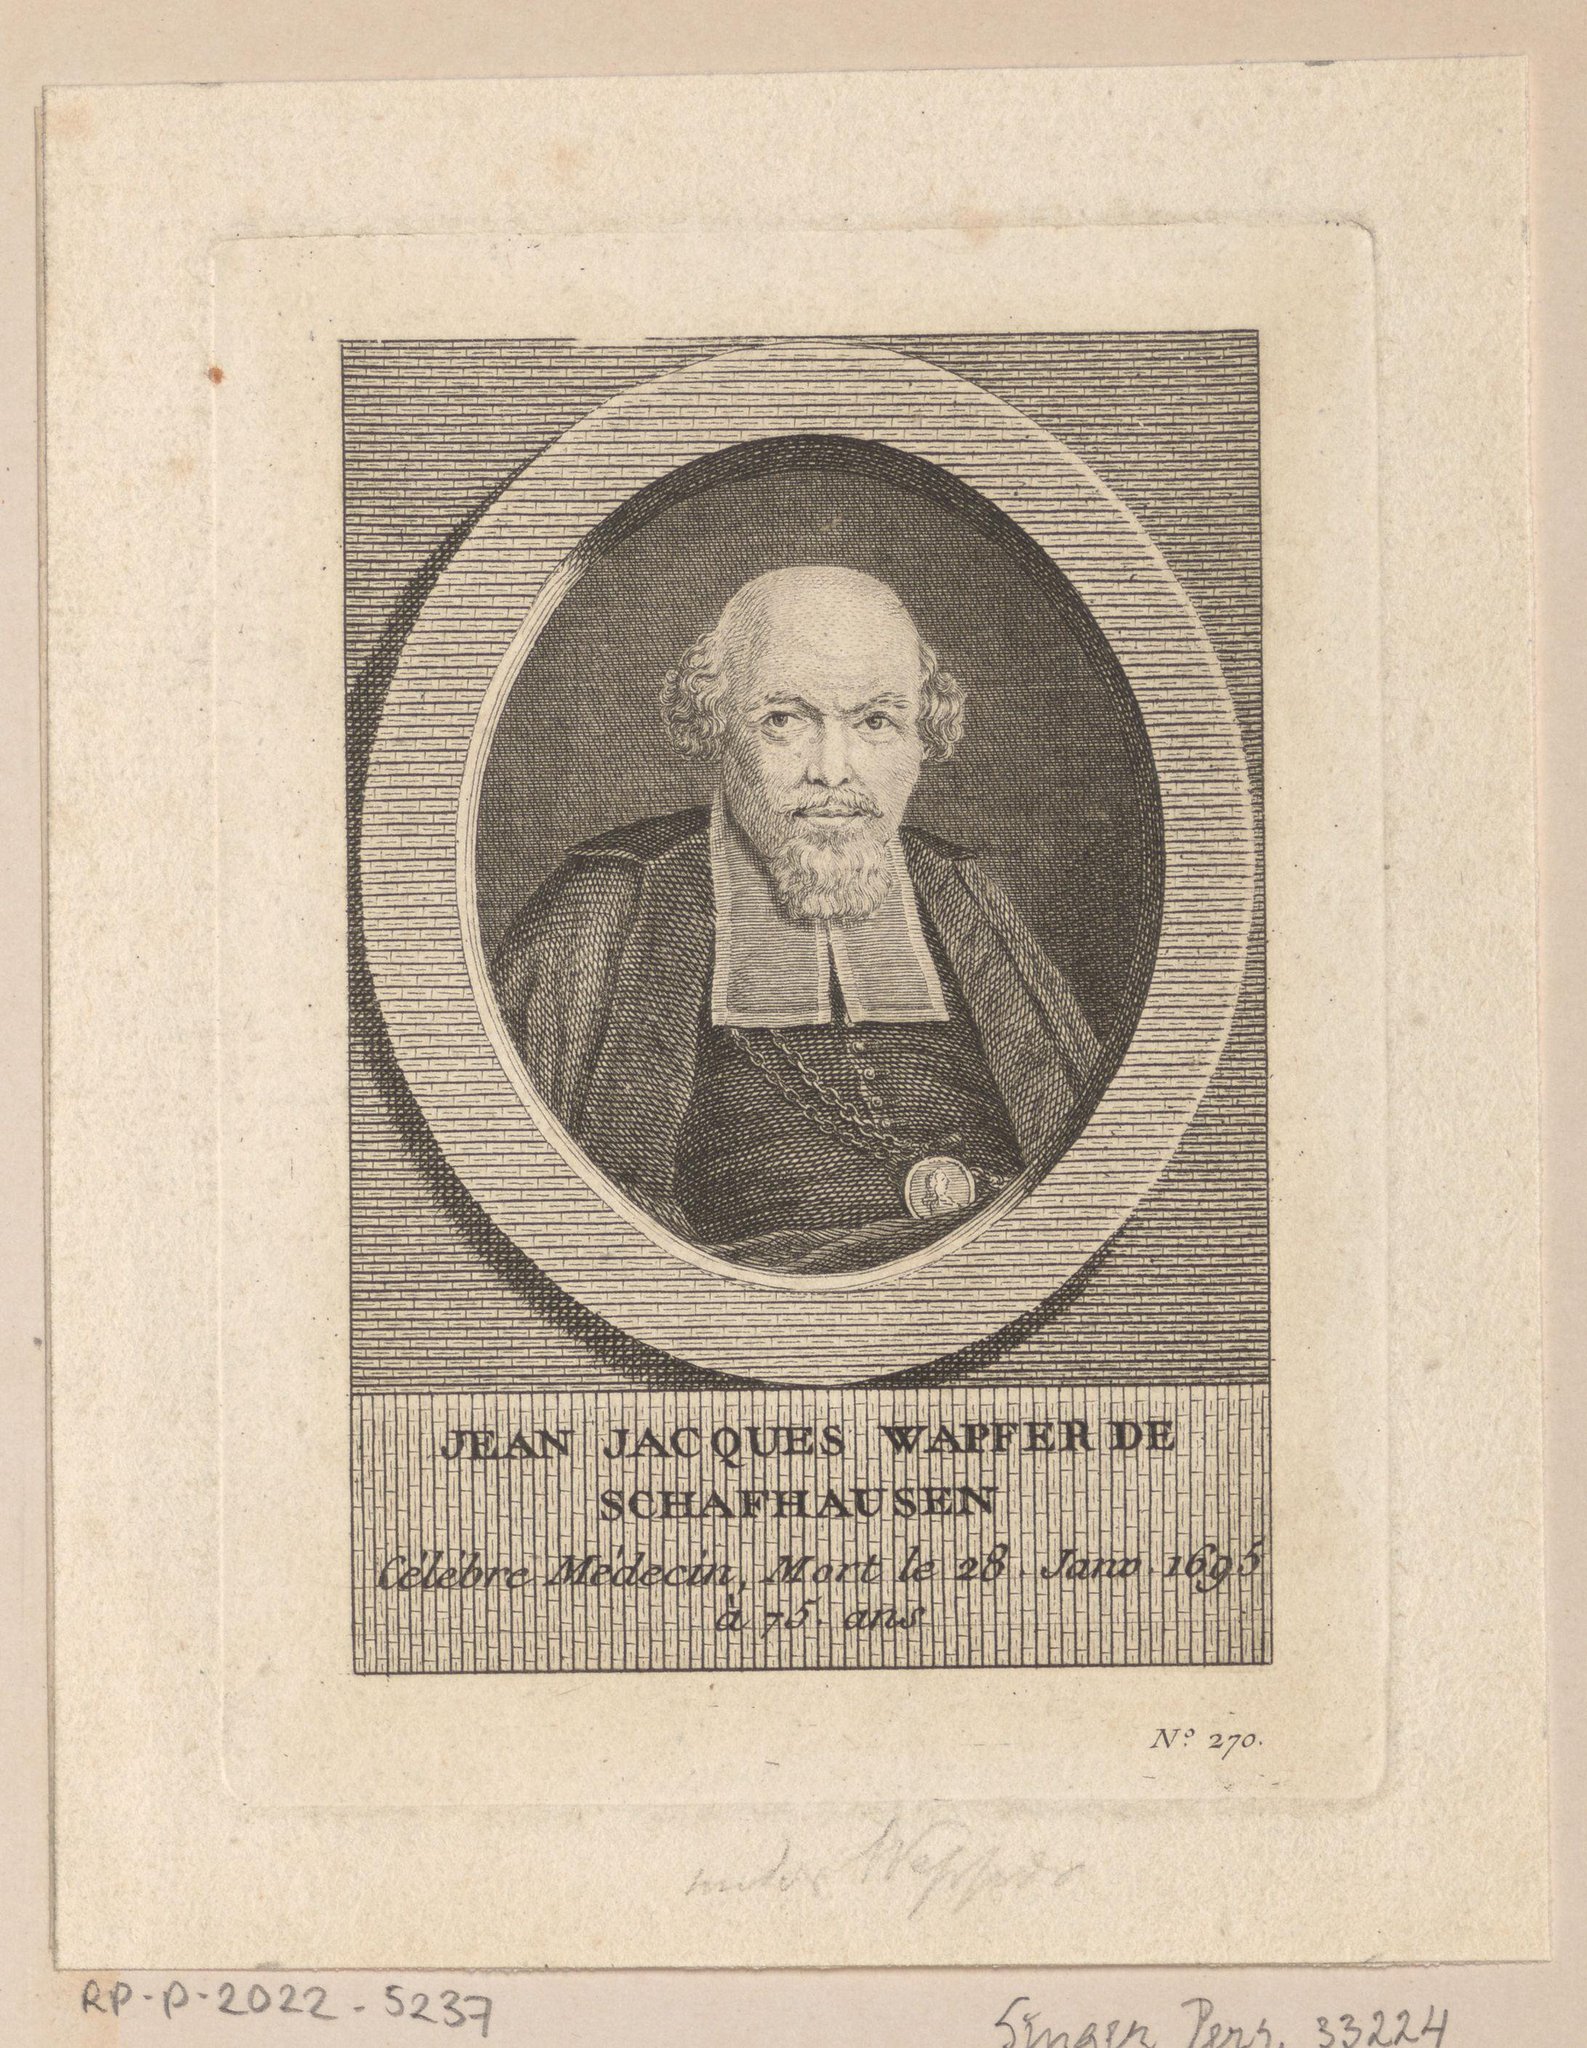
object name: print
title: Portret van Johann Jakob Wepfer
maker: Anonymous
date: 1784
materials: paper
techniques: engraving, etching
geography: france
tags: historical persons, pendant, trinket, 'breloque'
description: Andere staat van prent, met paginanummer boven portret, gebruikt in: Zurlauben, Béat Fidèle Antoine Dominique. Tableaux de la Suisse, ou Voyage pittoresque fait dans les XIII cantons du corps helvétique (...). Parijs: Lamy libraire, 1784, dl. 7.